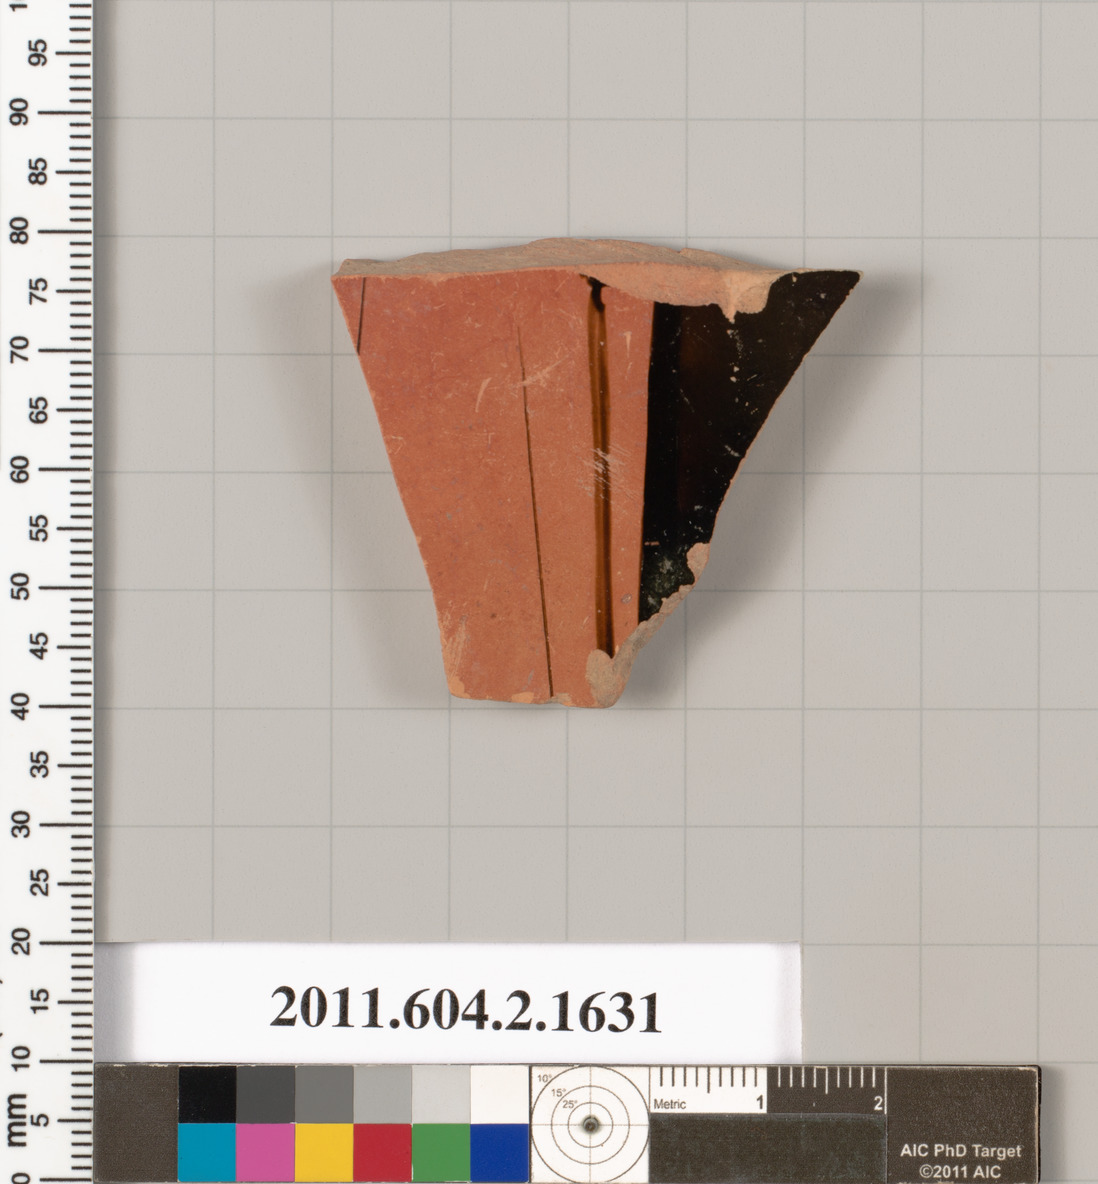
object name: skyphos fragment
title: Terracotta fragment of a skyphos (deep drinking cup)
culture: greek, attic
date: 460-440 BCE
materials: terracotta